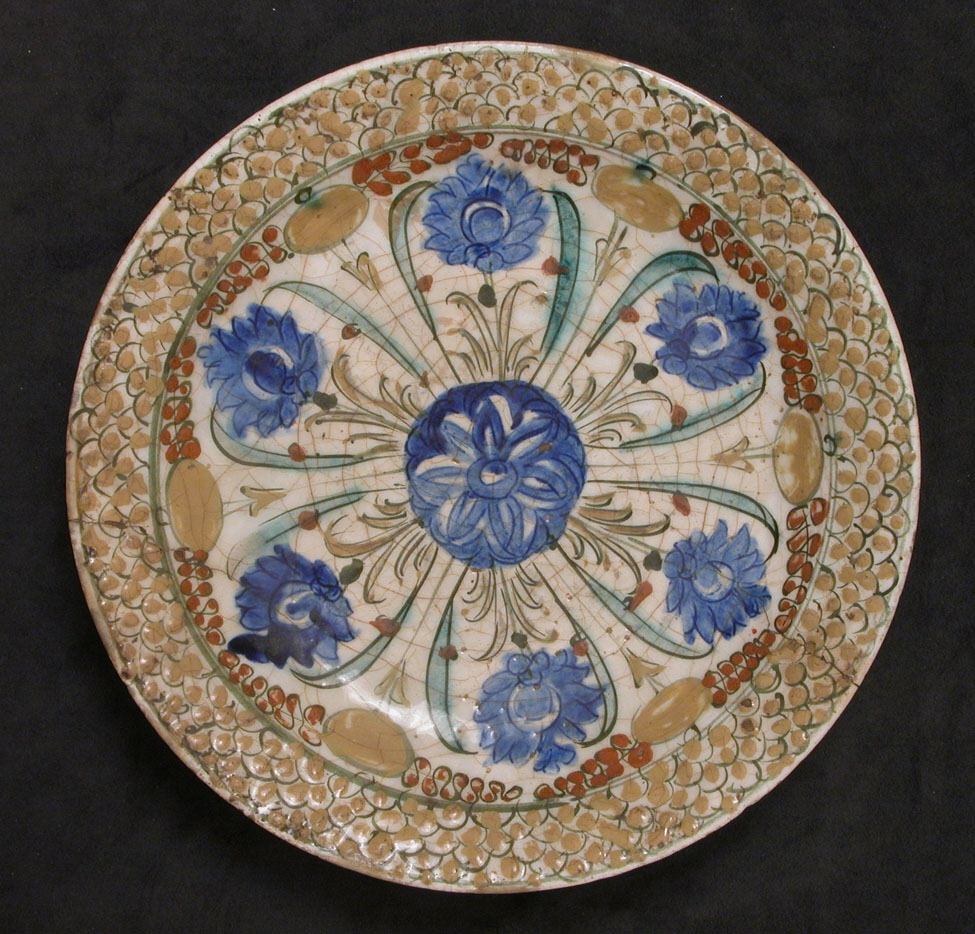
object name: dish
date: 1601-1700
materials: stonepaste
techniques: painting, underglaze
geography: iran